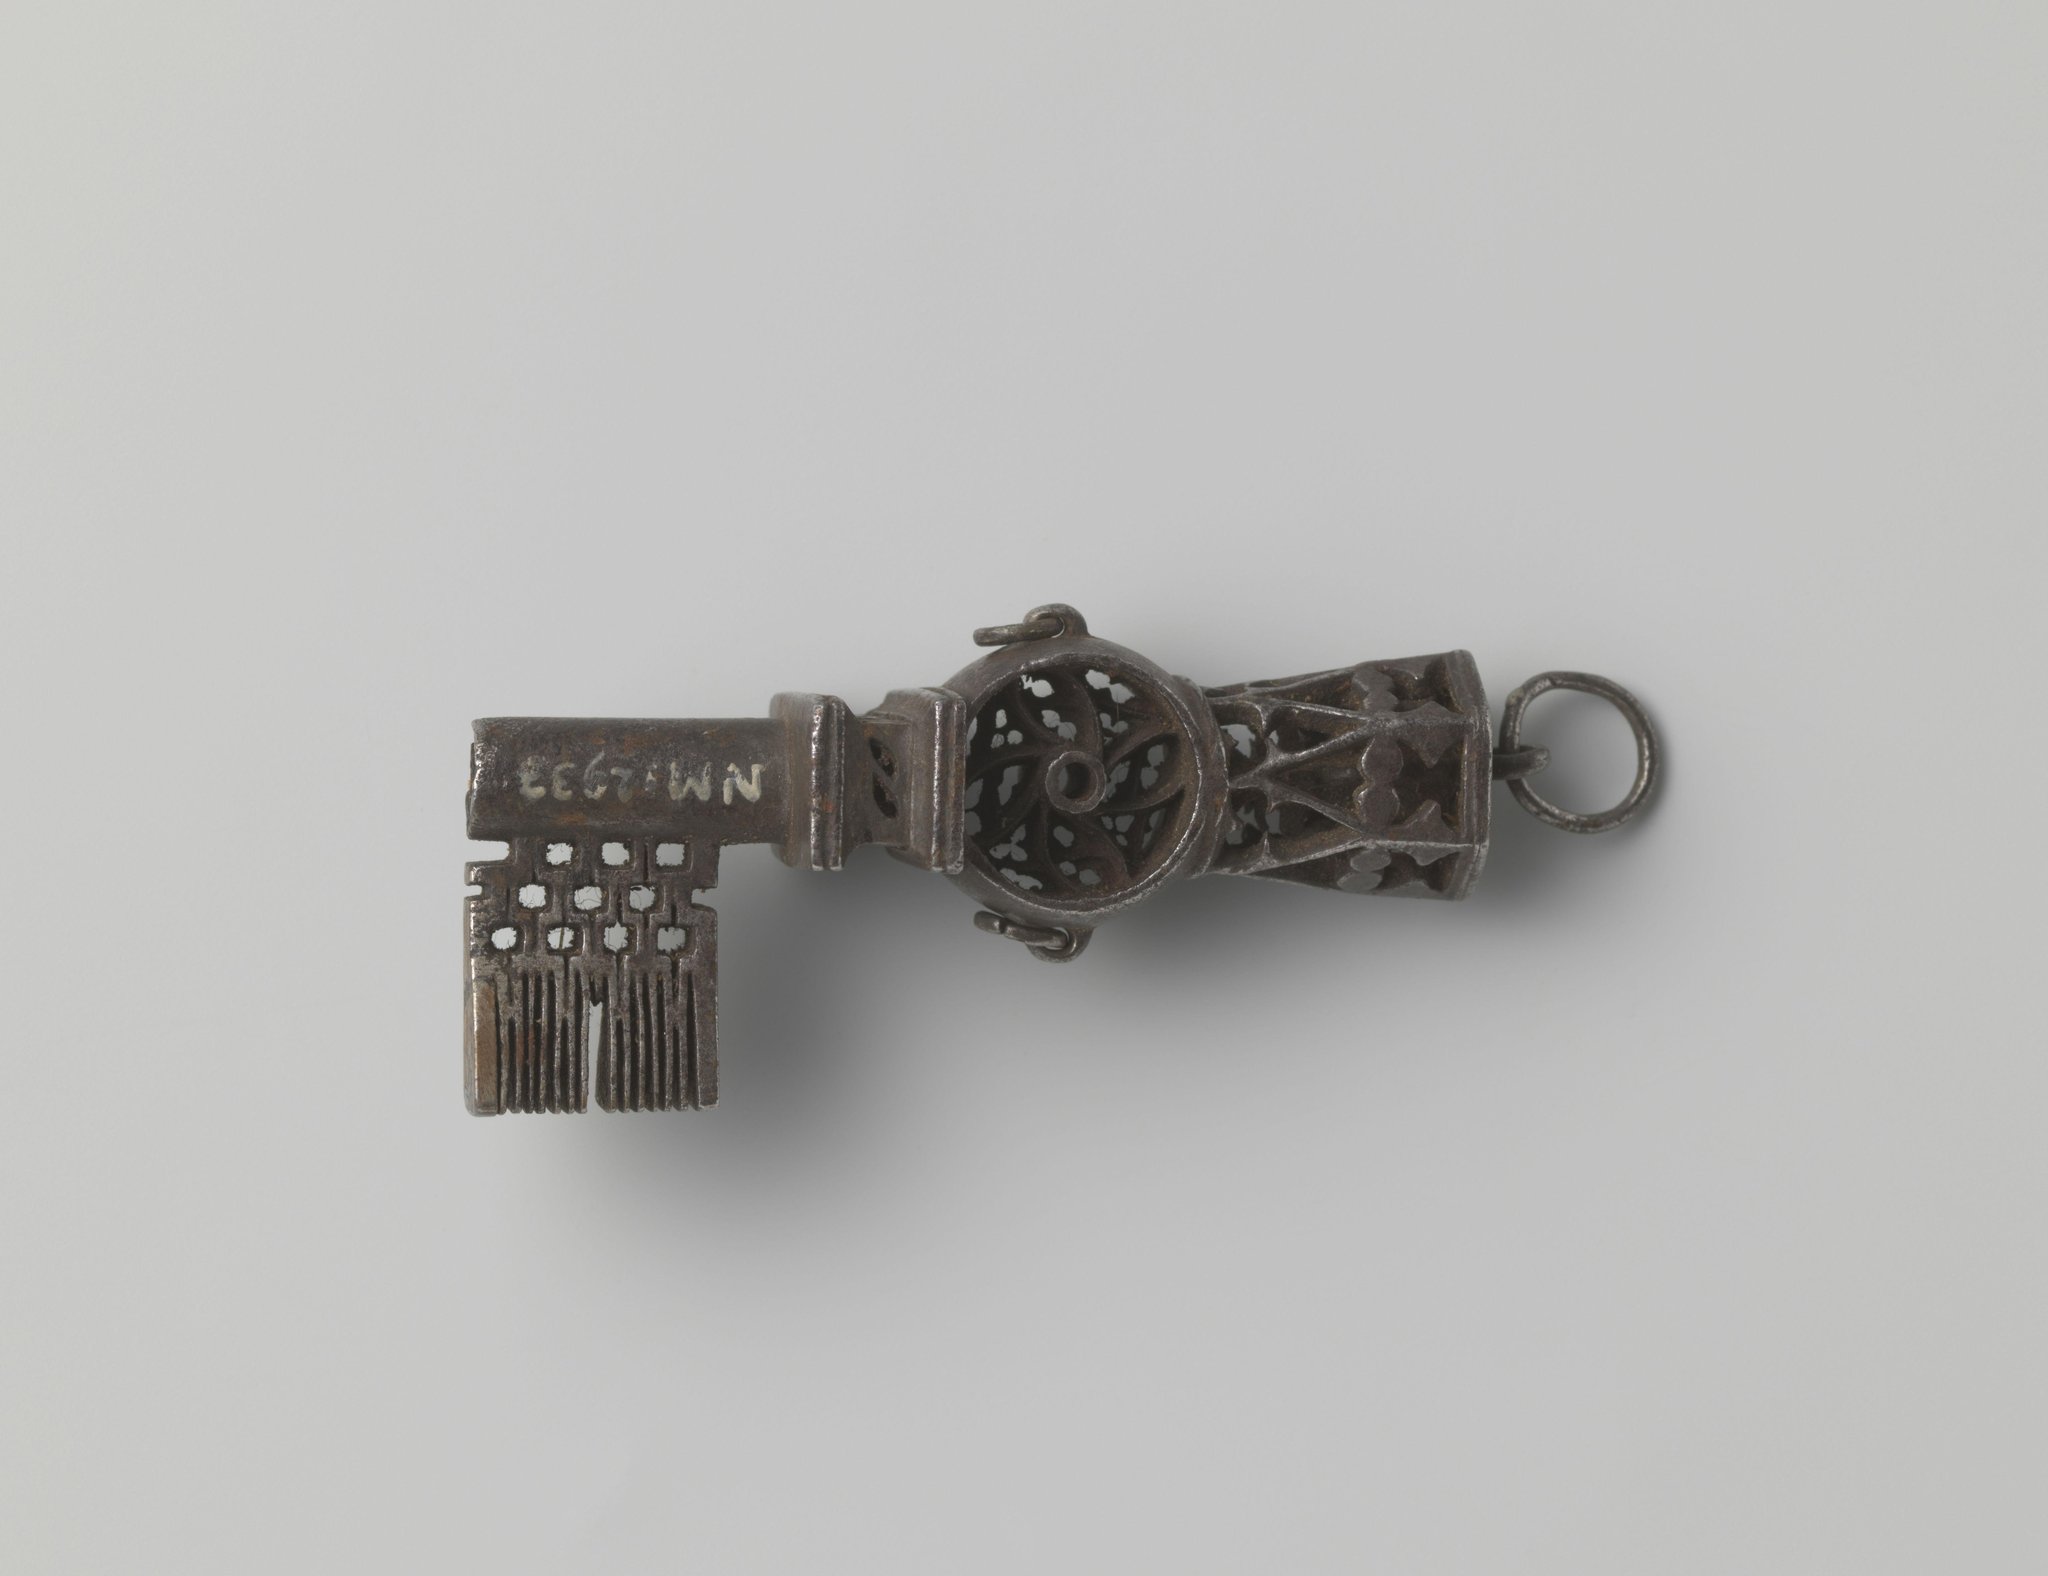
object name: key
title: Sleutel van ijzer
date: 1475-1525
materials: iron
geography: france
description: Gesmeed ijzeren sleutel. De ring is geheel opengewerkt; aan de bovenzijde zeskant met lelie-vormige versieringen, daaronder dwars een rond gedeelte met traceeringvormig vulsel. Een opengewerkte rechthoekig dwarsstuk verbindt ring en pijp. De pijp is hol en dubbel. De baard zeer fijn gebladerd en aan de stootkant open.